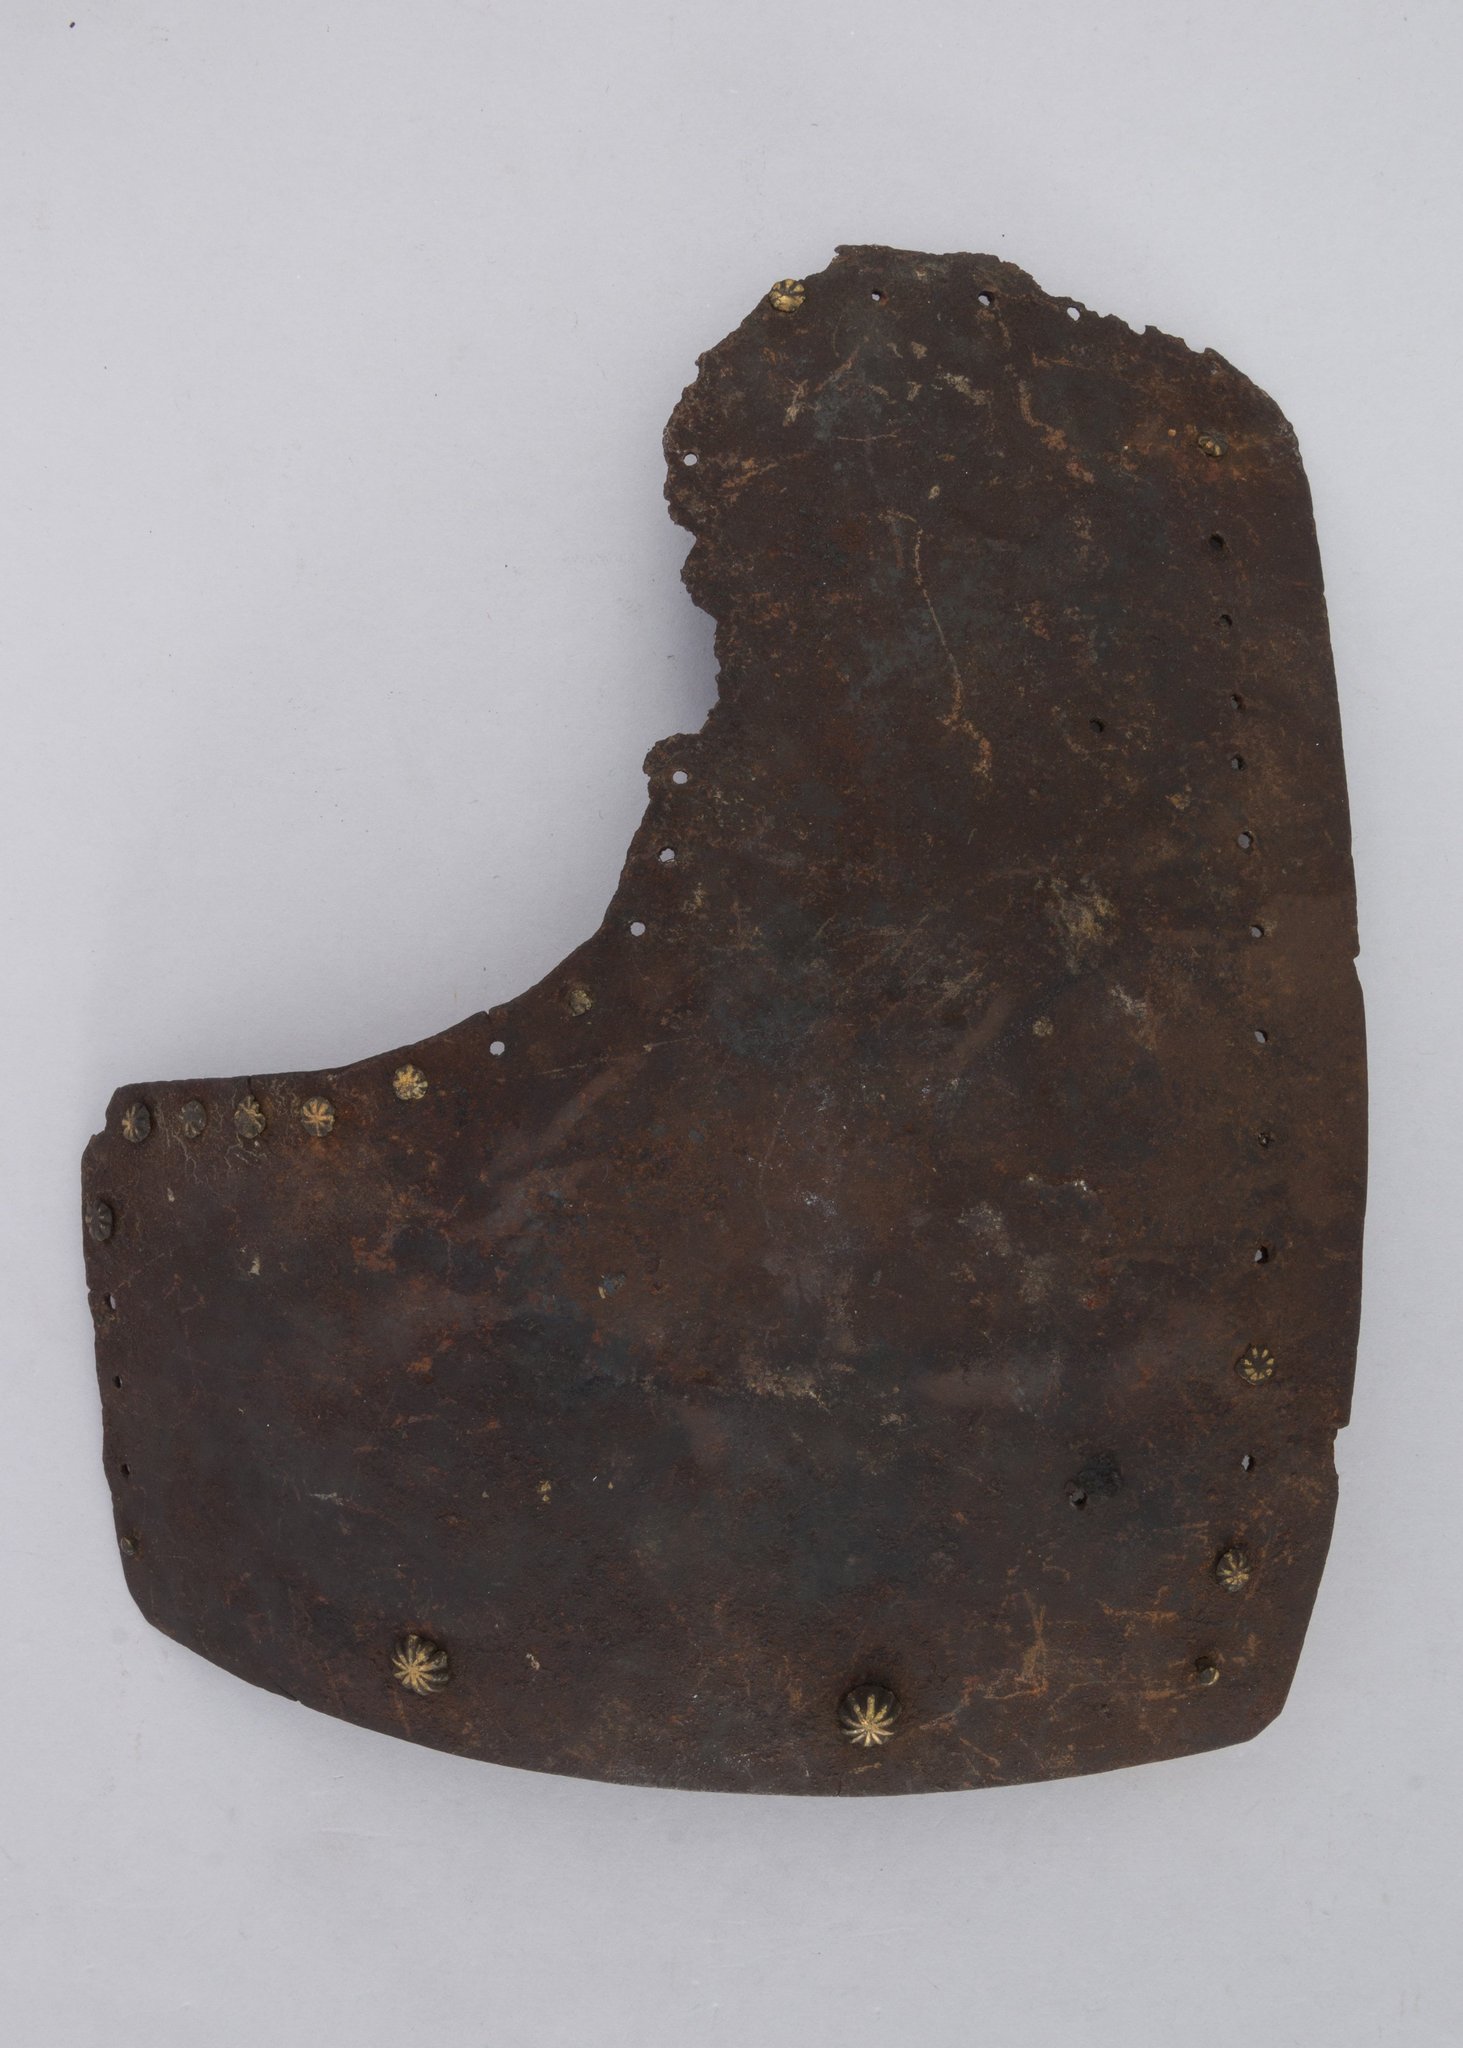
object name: brigandine plate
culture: italian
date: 1400-1450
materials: metal alloy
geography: italy